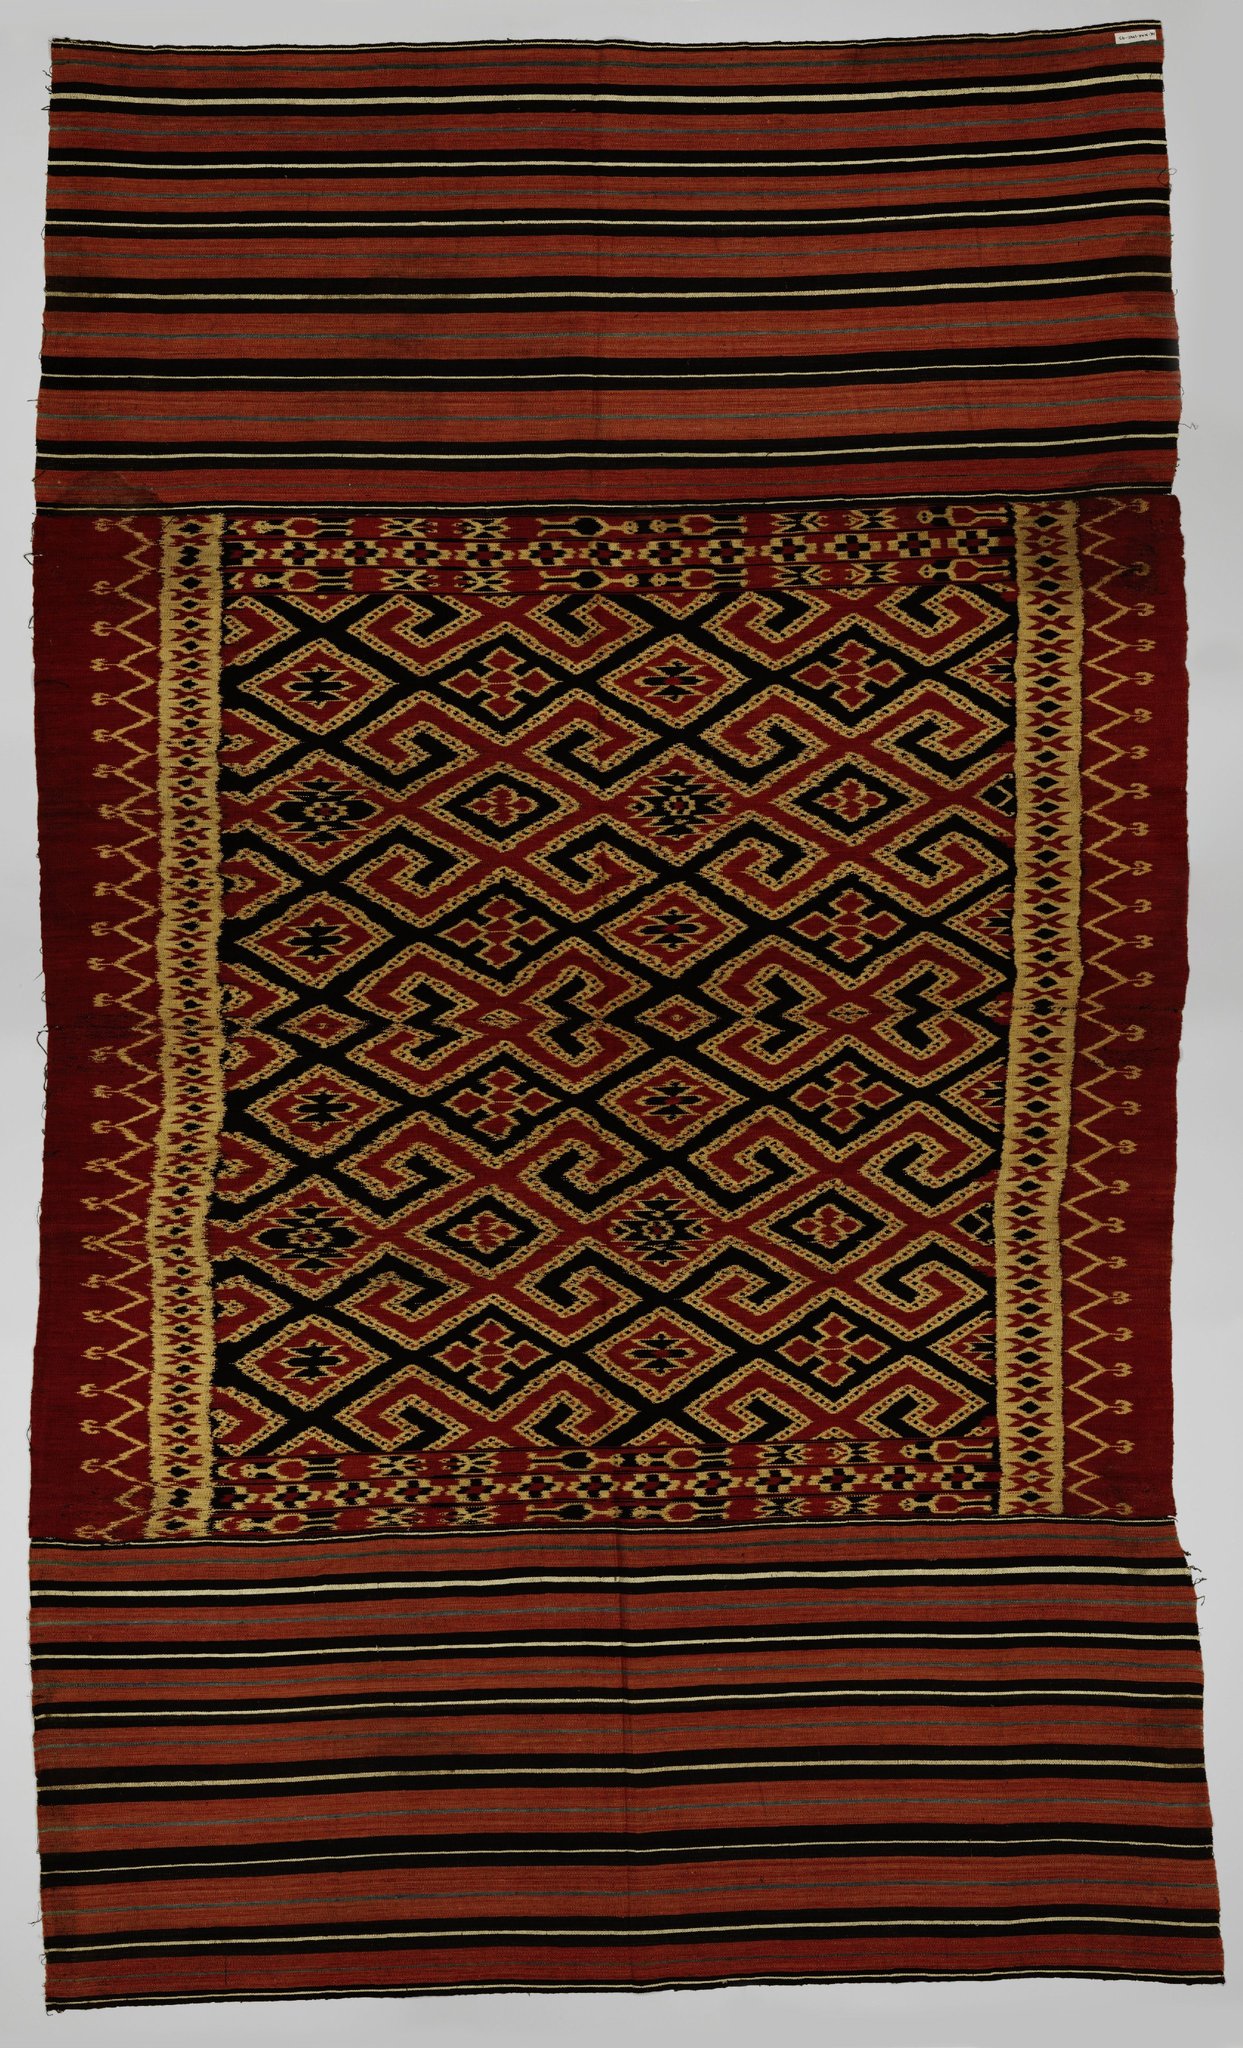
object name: cloth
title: Dodendoek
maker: Anonymous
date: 1900-1949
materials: cotton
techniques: weave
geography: sulawesi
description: De dodendoeken van de Toraja bevolking uit Centraal Sulawesi behoren tot de meest spectaculaire doeken van de archipel. Ze zijn meer dan vier meter lang en versierd met slangenhuid-achtige (patola) motieven. De doeken zijn buiten het Toraja gebied vervaardigd. Deze doeken zijn gebruikt als wandversiering in de doodskamer, als lijkwade of als kleding. De doeken hebben de typische Toraja kleuren: zwart, rood en wit. Zwart symboliseert het einde van het leven en rood het bloed van offerdieren. Wit is de kleur van de allerhoogste Godheid.